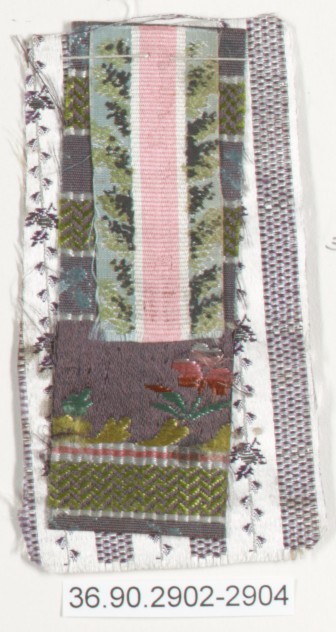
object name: piece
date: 1801-1900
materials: silk